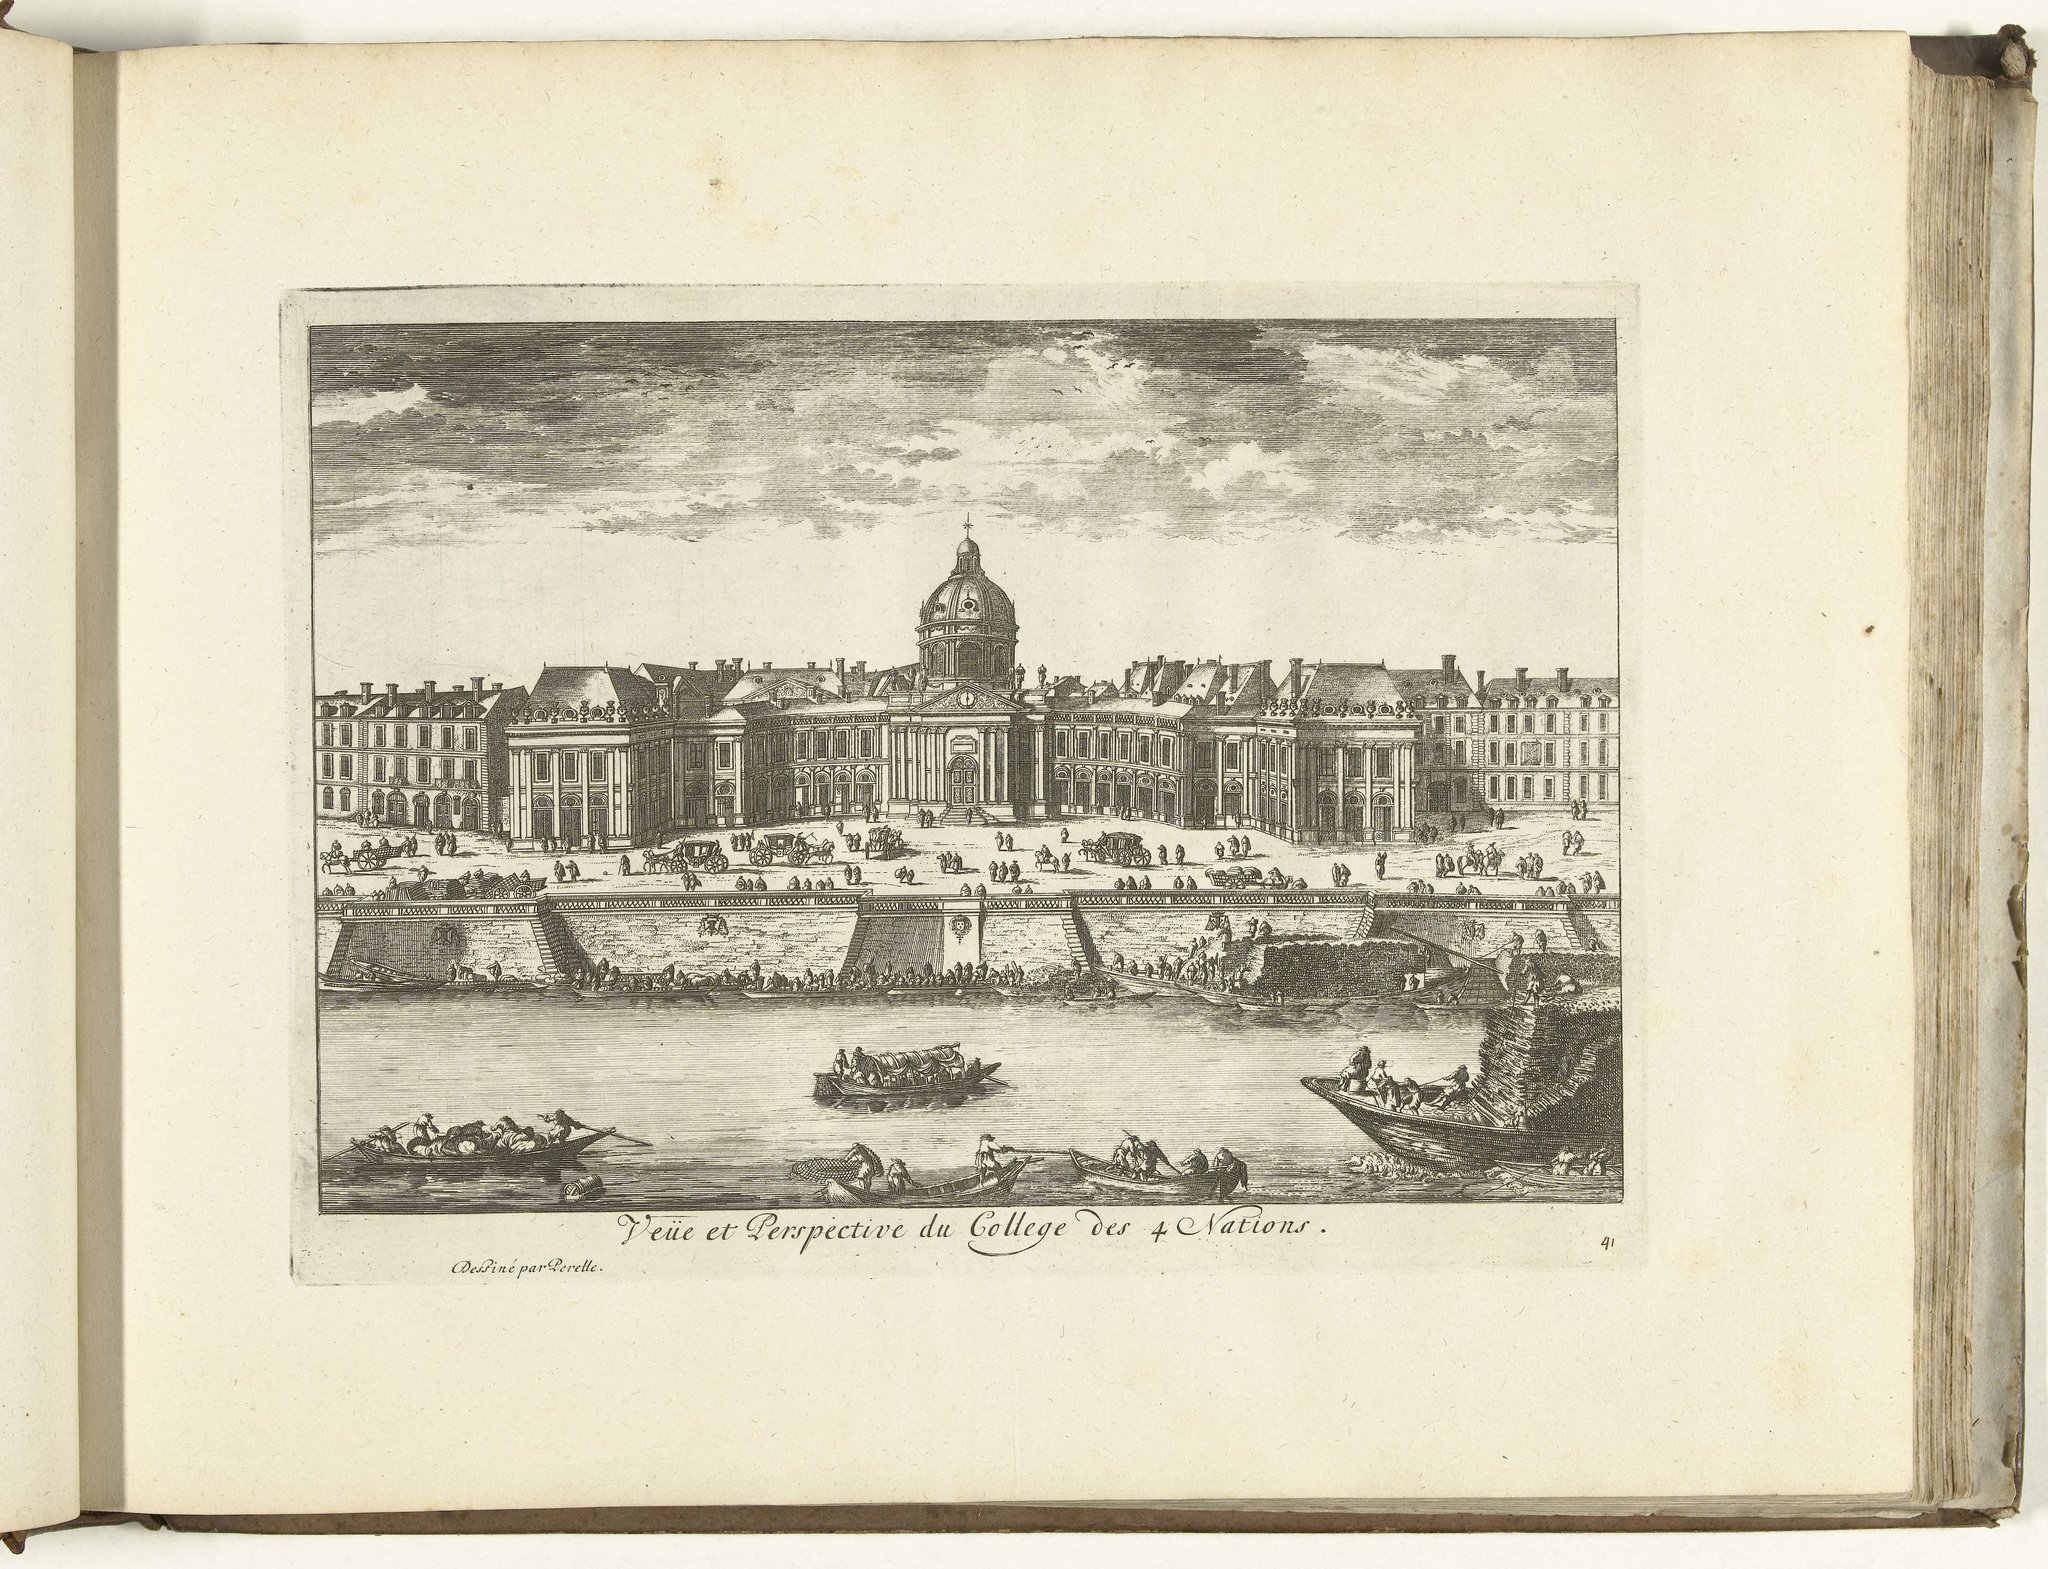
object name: print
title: Gezicht op het Collège des Quatre-Nations te Parijs, 1726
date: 1726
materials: paper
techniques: etching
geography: northern netherlands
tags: collège des quatre-nations, spaanse successieoorlog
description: Gezicht op het Collège des Quatre-Nations te Parijs. Plaat nr. 41 in deel II van het prentwerk: Les Forces de l'Europe, Asie, Afrique et Amerique ... Comme aussi les Cartes des Côtes de France et d'Espagne uit 1726, dit eerste deel met 238 met de hand genummerde platen van vermaarde sterke steden en vestingen in het kader van de Spaanse Successieoorlog 1701-1713. Voor het merendeel zijn deze platen gekopieerd naar de anonieme Franse platen van vermaarde sterke steden en vestingen: in Les forces de l'Europe en in: Le theatre de la guerre, dans les Pays-Bas, beide oorspronkelijk uitgegeven door Nicolas de Fer te Parijs (1693-1697) in het kader van de Negenjarige Oorlog. Titel en opschriften in het Frans.